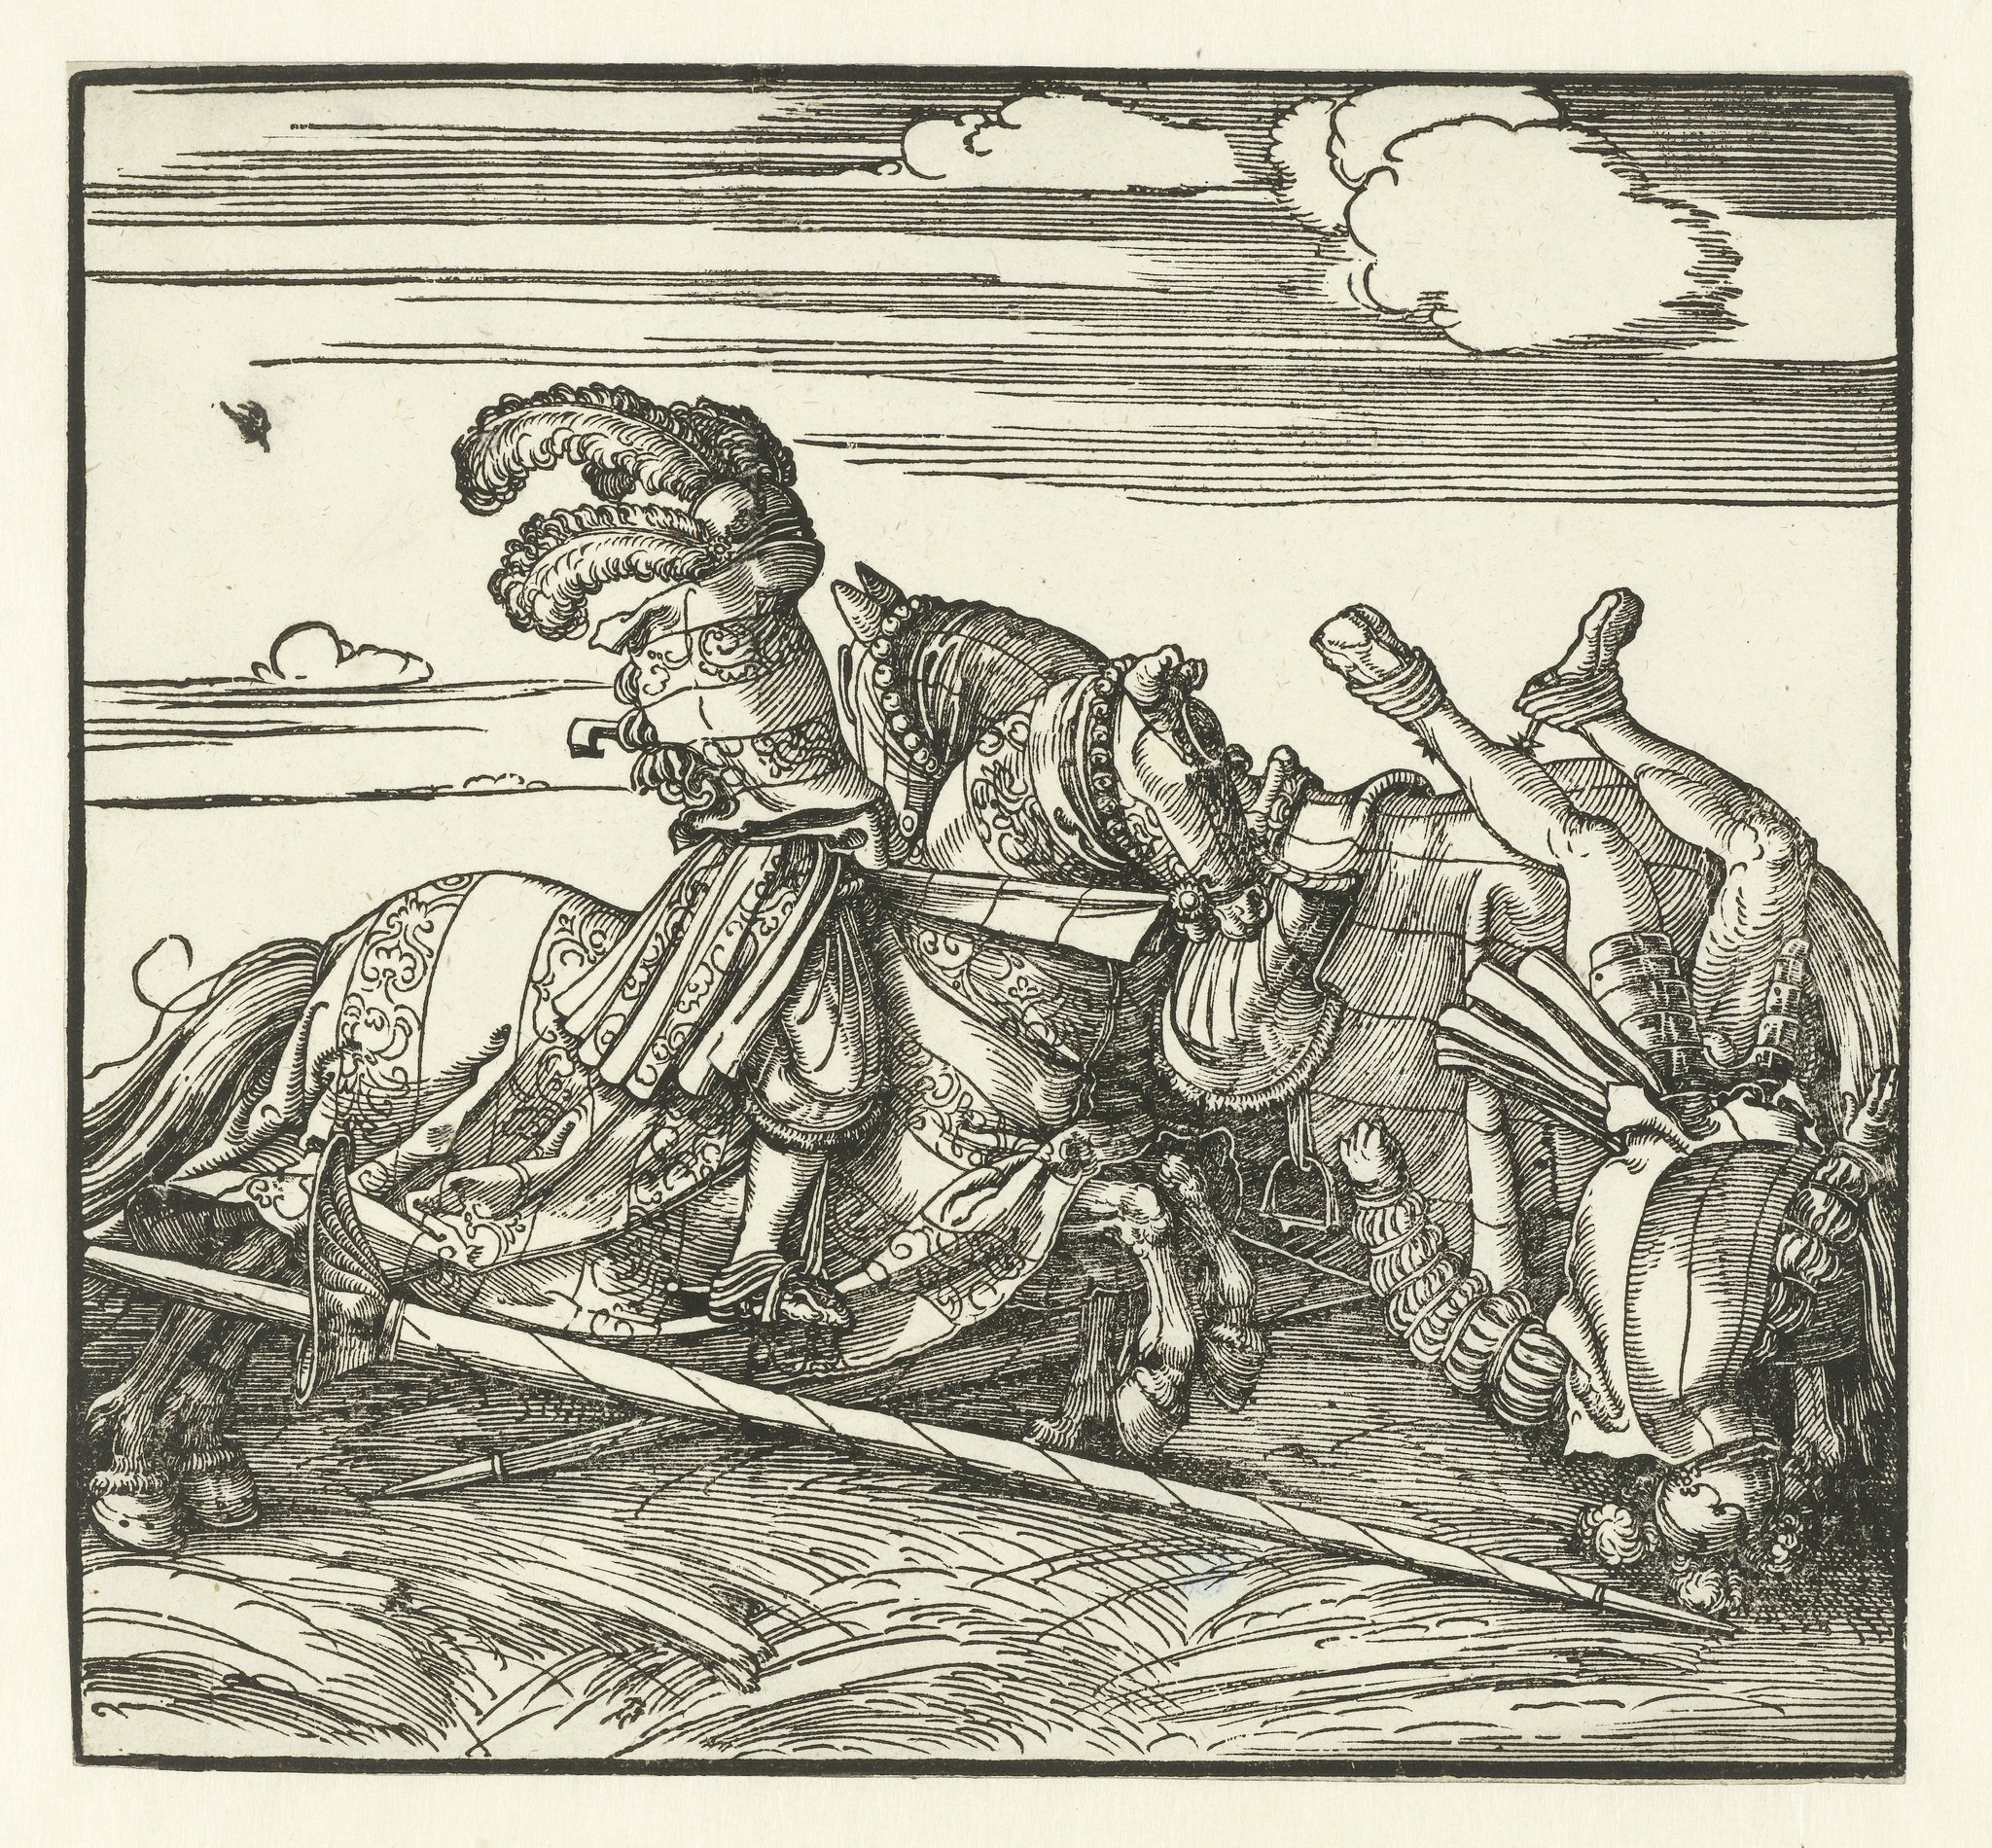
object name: book illustration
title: Twee ruiters in gevecht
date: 1517-1518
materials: paper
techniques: woodcut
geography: nuremberg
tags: maximilian i (holy roman emperor), tournament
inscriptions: collector's mark: Lugt 1185, collector's mark: Lugt 2228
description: Een ridder te paard (Freydal) heeft een andere ridder (Niklas von Firmian) met zijn speer uit het zadel geworpen. Deze prent is onderdeel van een serie illustraties voor het verhaal 'Freydal', over de gelijknamige ridder, bedoeld als verheerlijking van de daden van keizer Maximiliaan I.